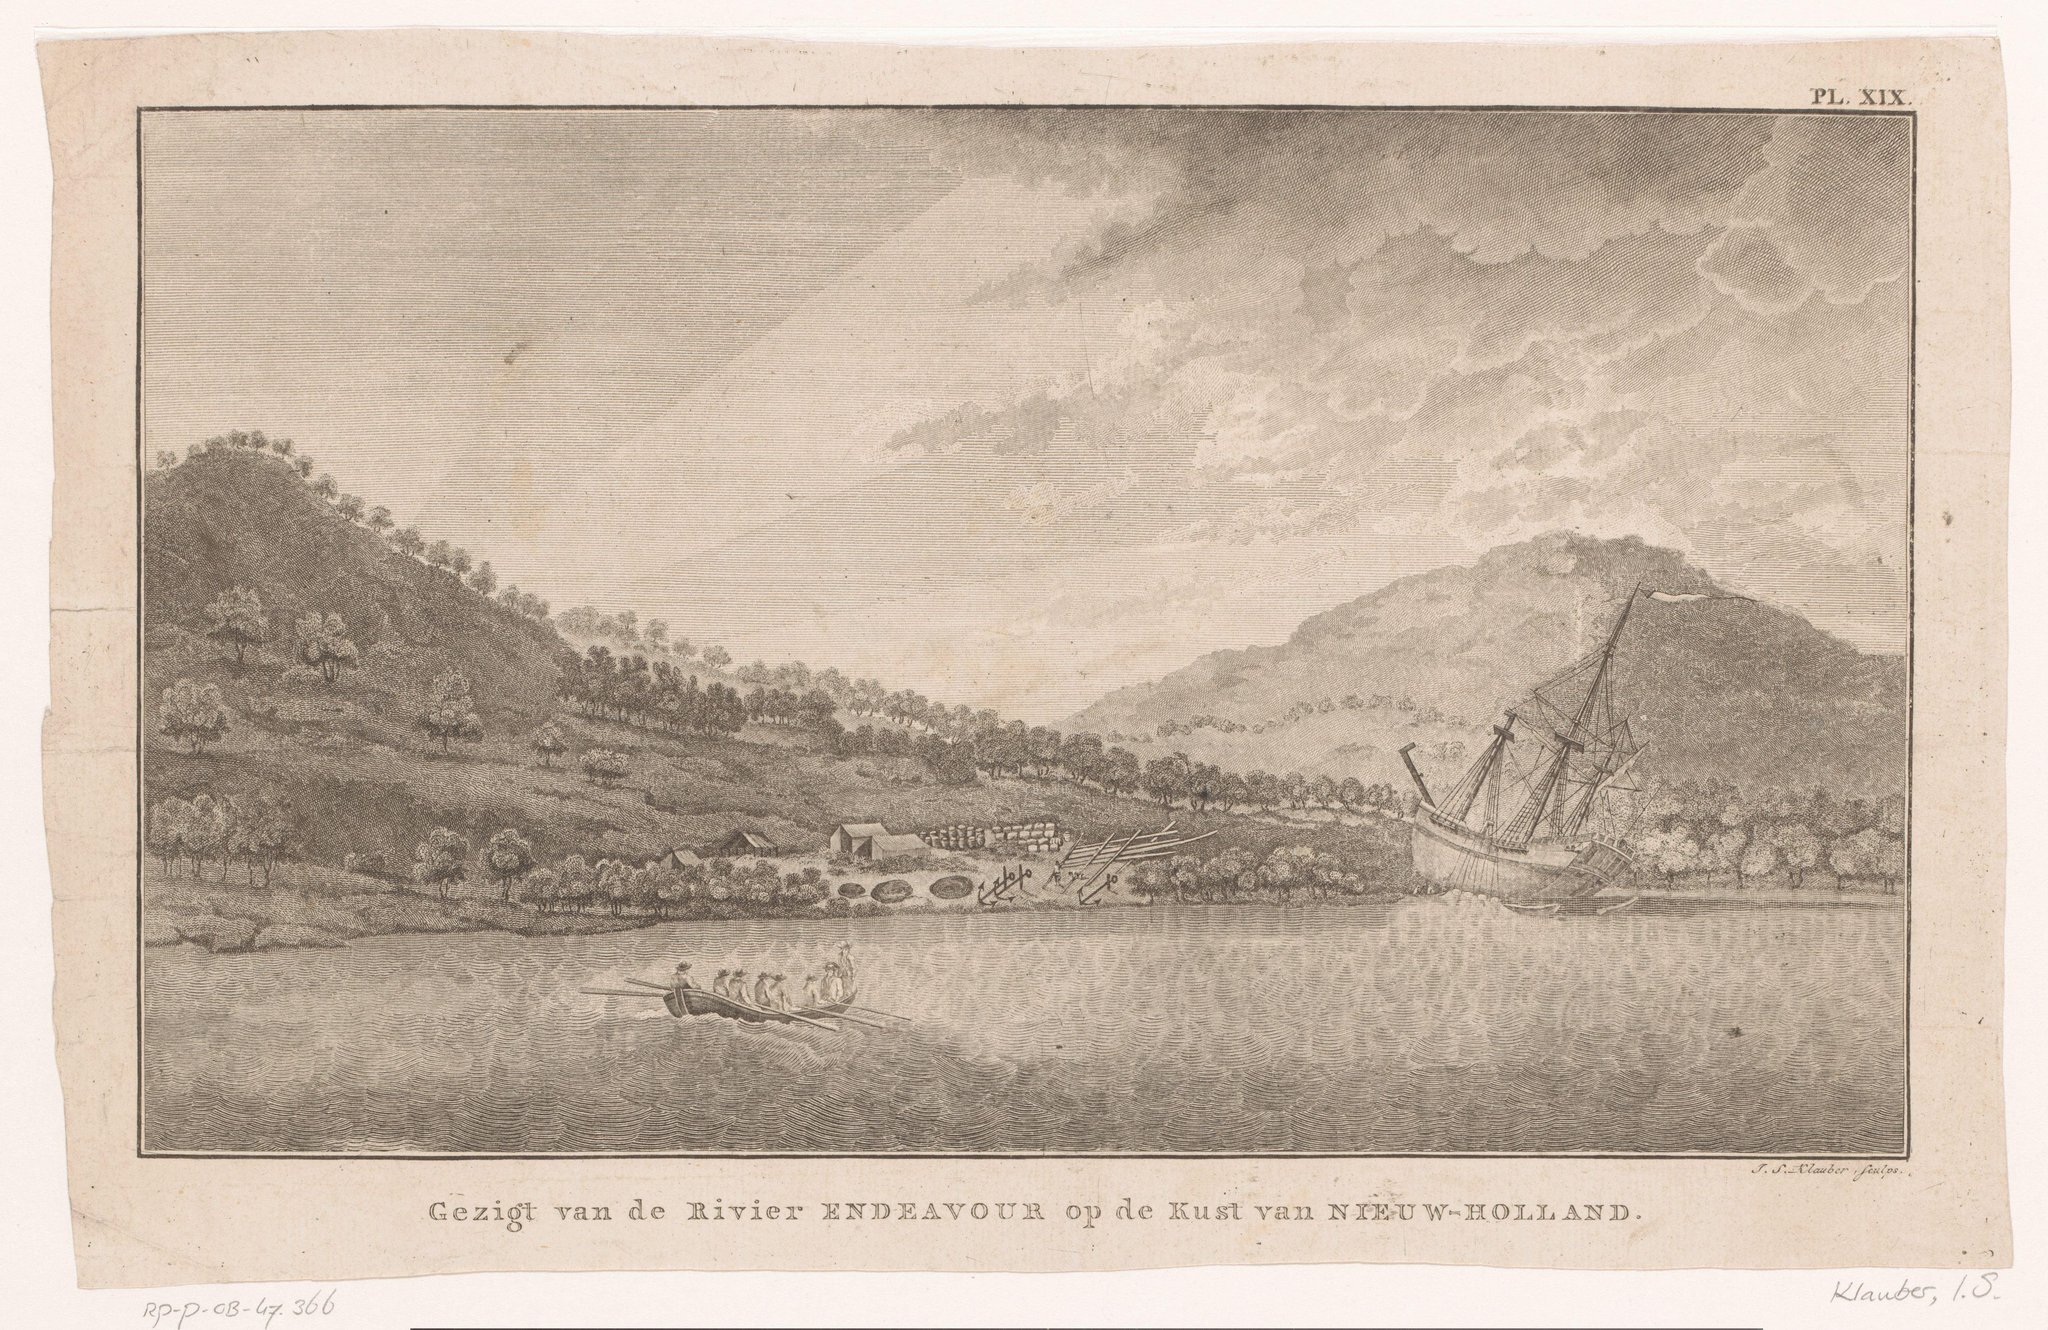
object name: print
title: Gezicht op de rivier Endeavour in Australië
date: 1798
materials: paper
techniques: engraving, etching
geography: amsterdam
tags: river, rowing-boat, canoe, etc., ships, boats on land, beached, australia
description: Prent uit: Cook, James. Reize rondom de Waereld (...) met kaarten en plaaten. [Vertaald uit het Engels door] Jan David Pasteur. Leiden: Honkoop, Amsterdam: Allart, Den Haag: Van Cleef, 1798, dl. 3, p. 119.